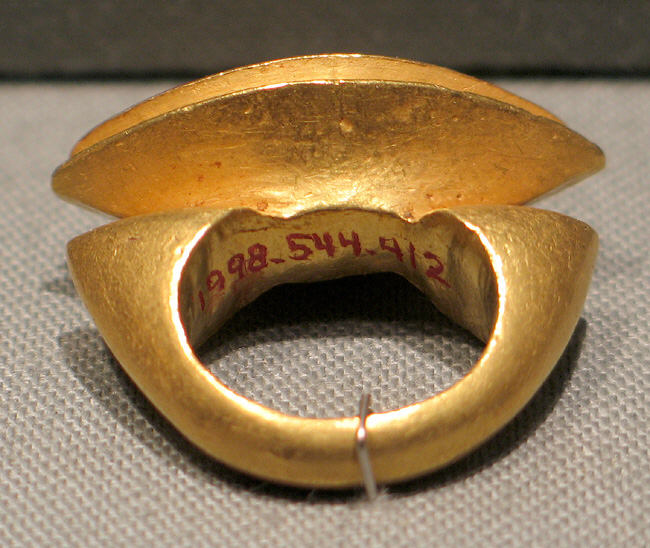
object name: ring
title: Stirrup-Shaped Ring with Oblong Bezel with Nagari Script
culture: indonesian, javanese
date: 701-933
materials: gold